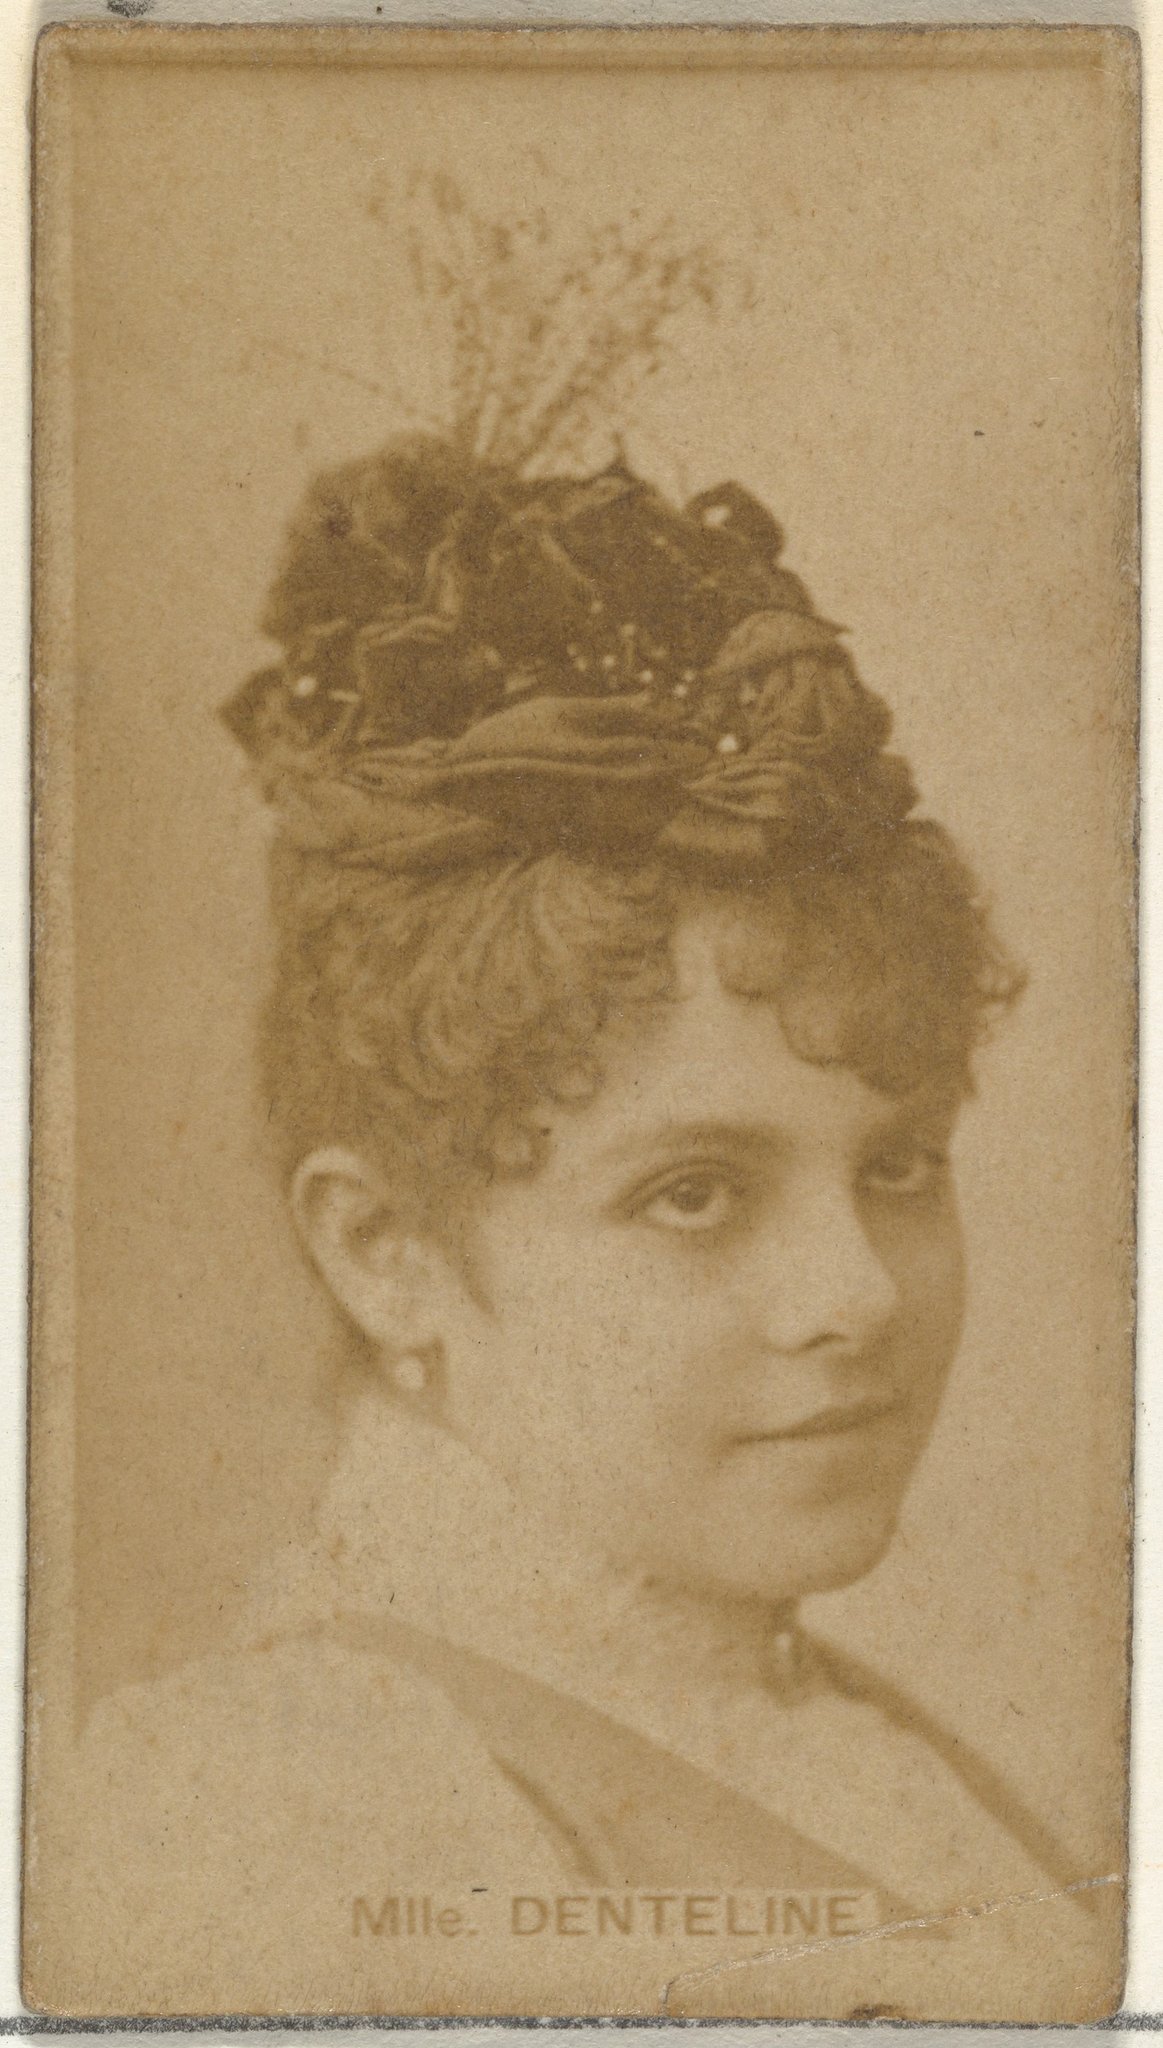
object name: photograph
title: Mlle. Denteline, from the Actors and Actresses series (N145-8) issued by Duke Sons & Co. to promote Duke Cigarettes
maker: w. duke, sons & co.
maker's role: publisher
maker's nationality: american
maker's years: 1870-1920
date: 1891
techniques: albumen silver print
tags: portraits,women,actresses